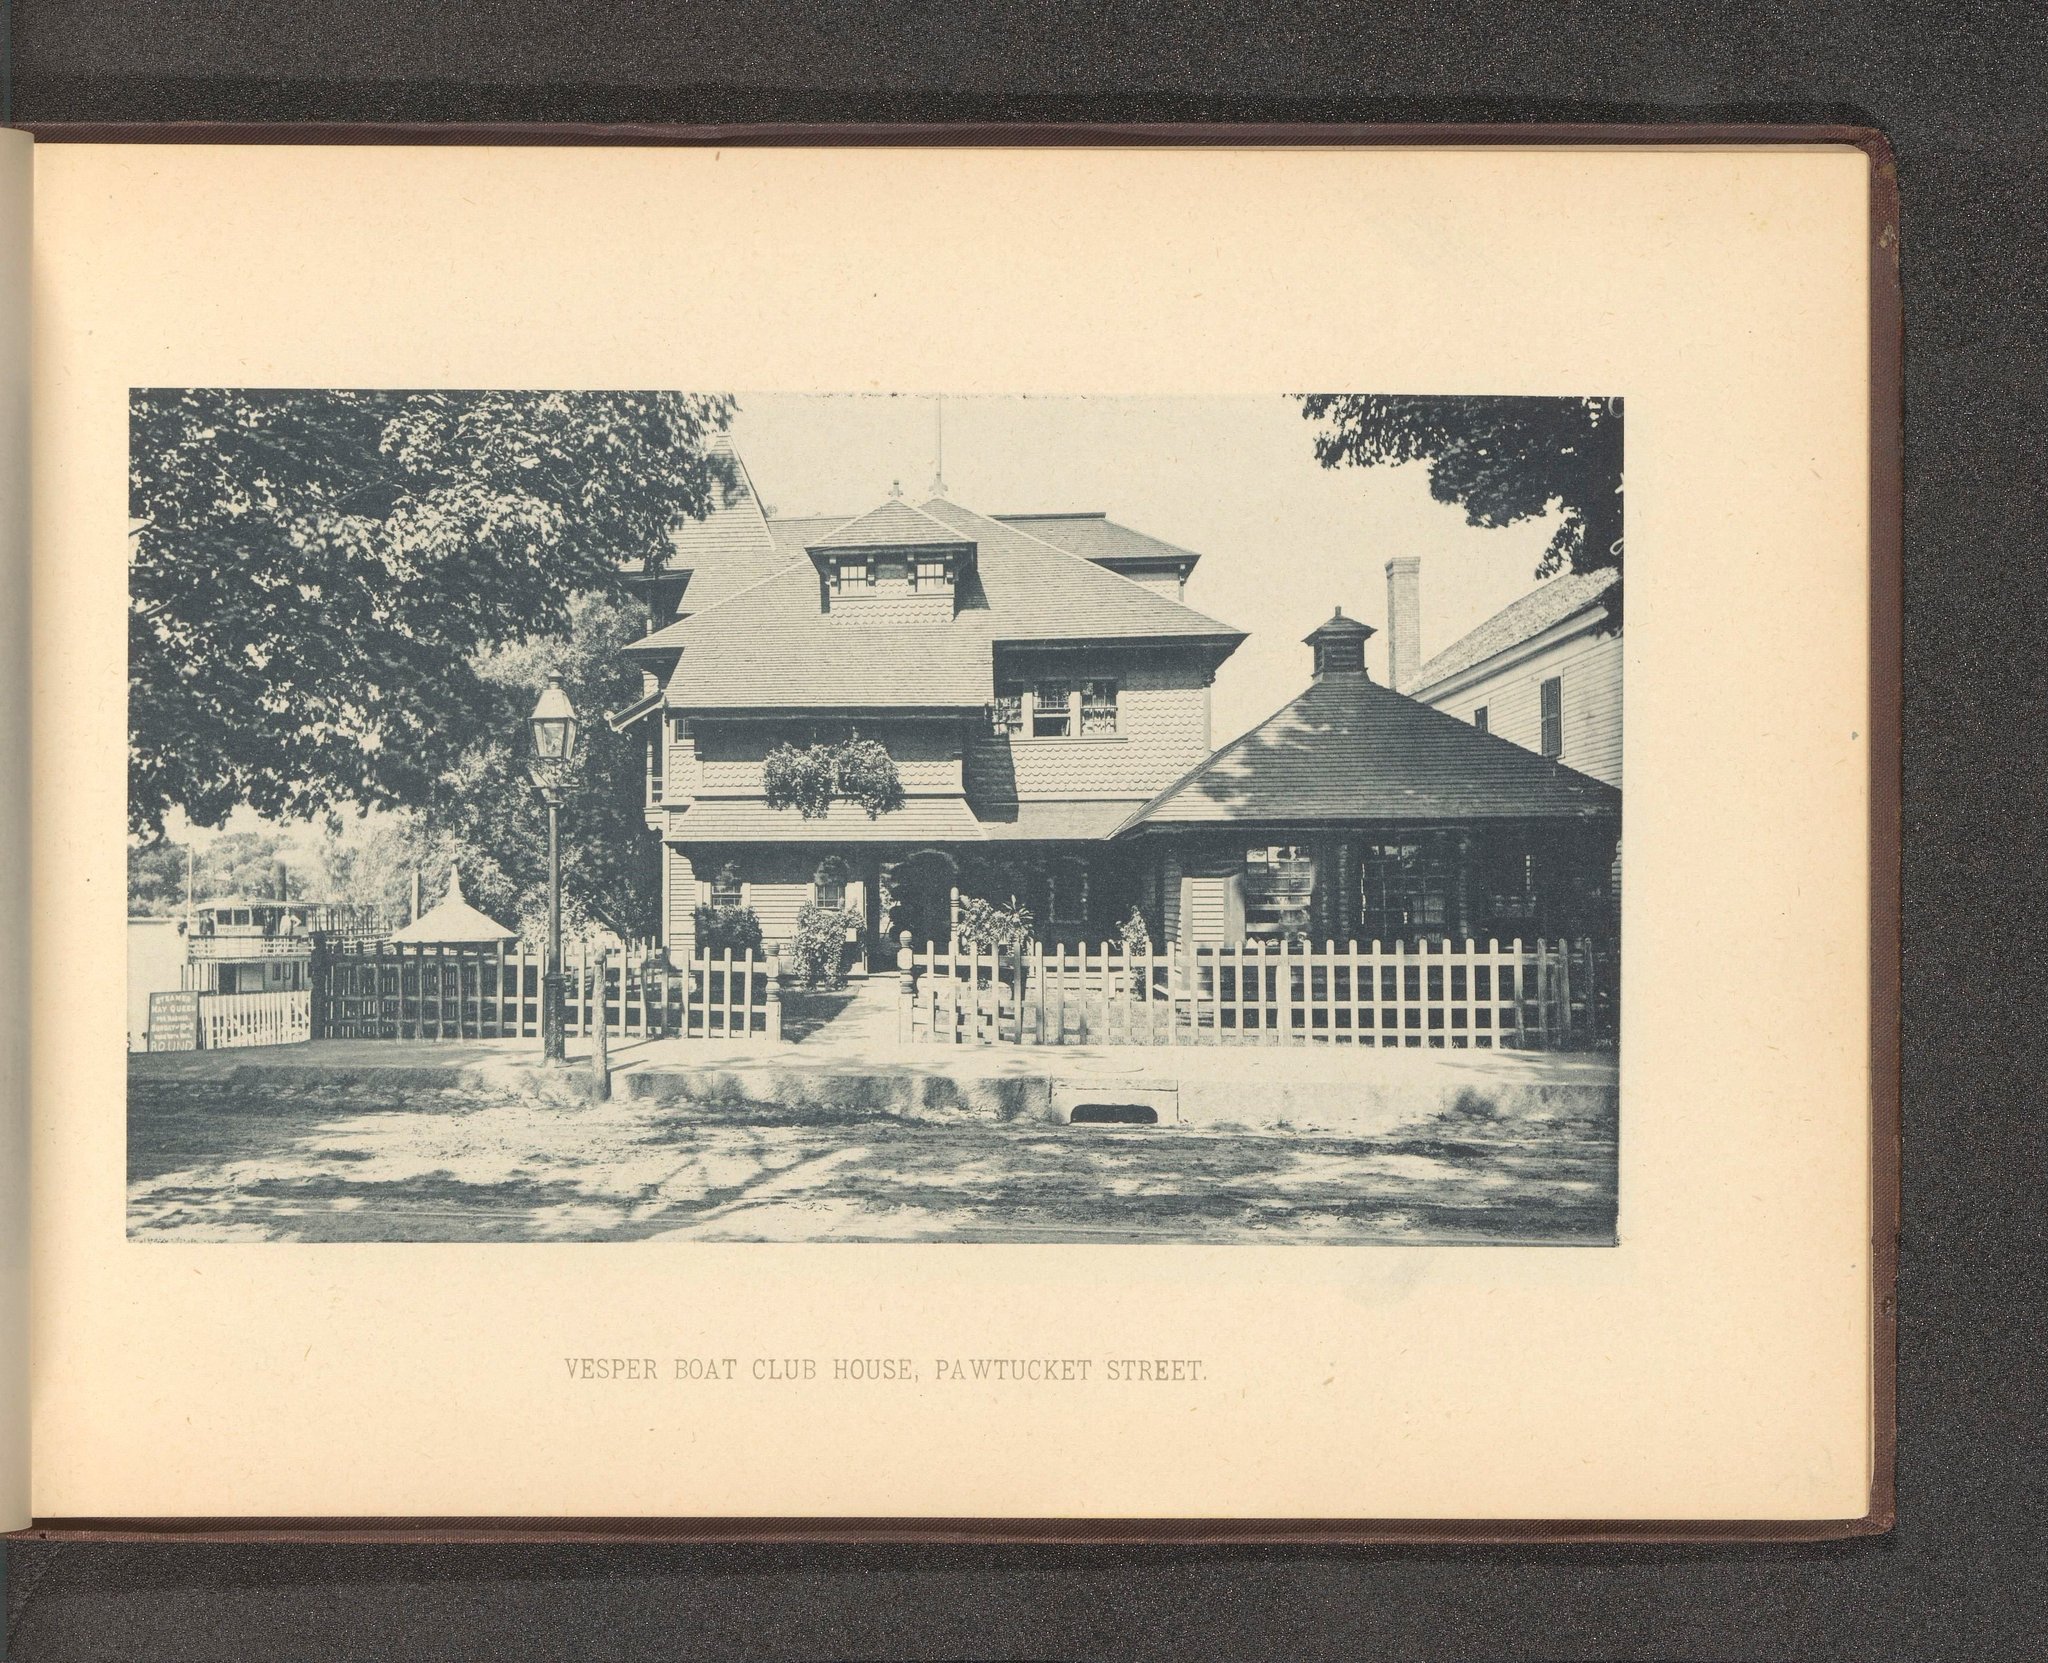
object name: page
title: Gezicht de botenclub op Pawtucket street te Lowell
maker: Anonymous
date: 1887-1892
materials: paper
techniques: photograph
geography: lowell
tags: club, meeting place, façade (of house or building)